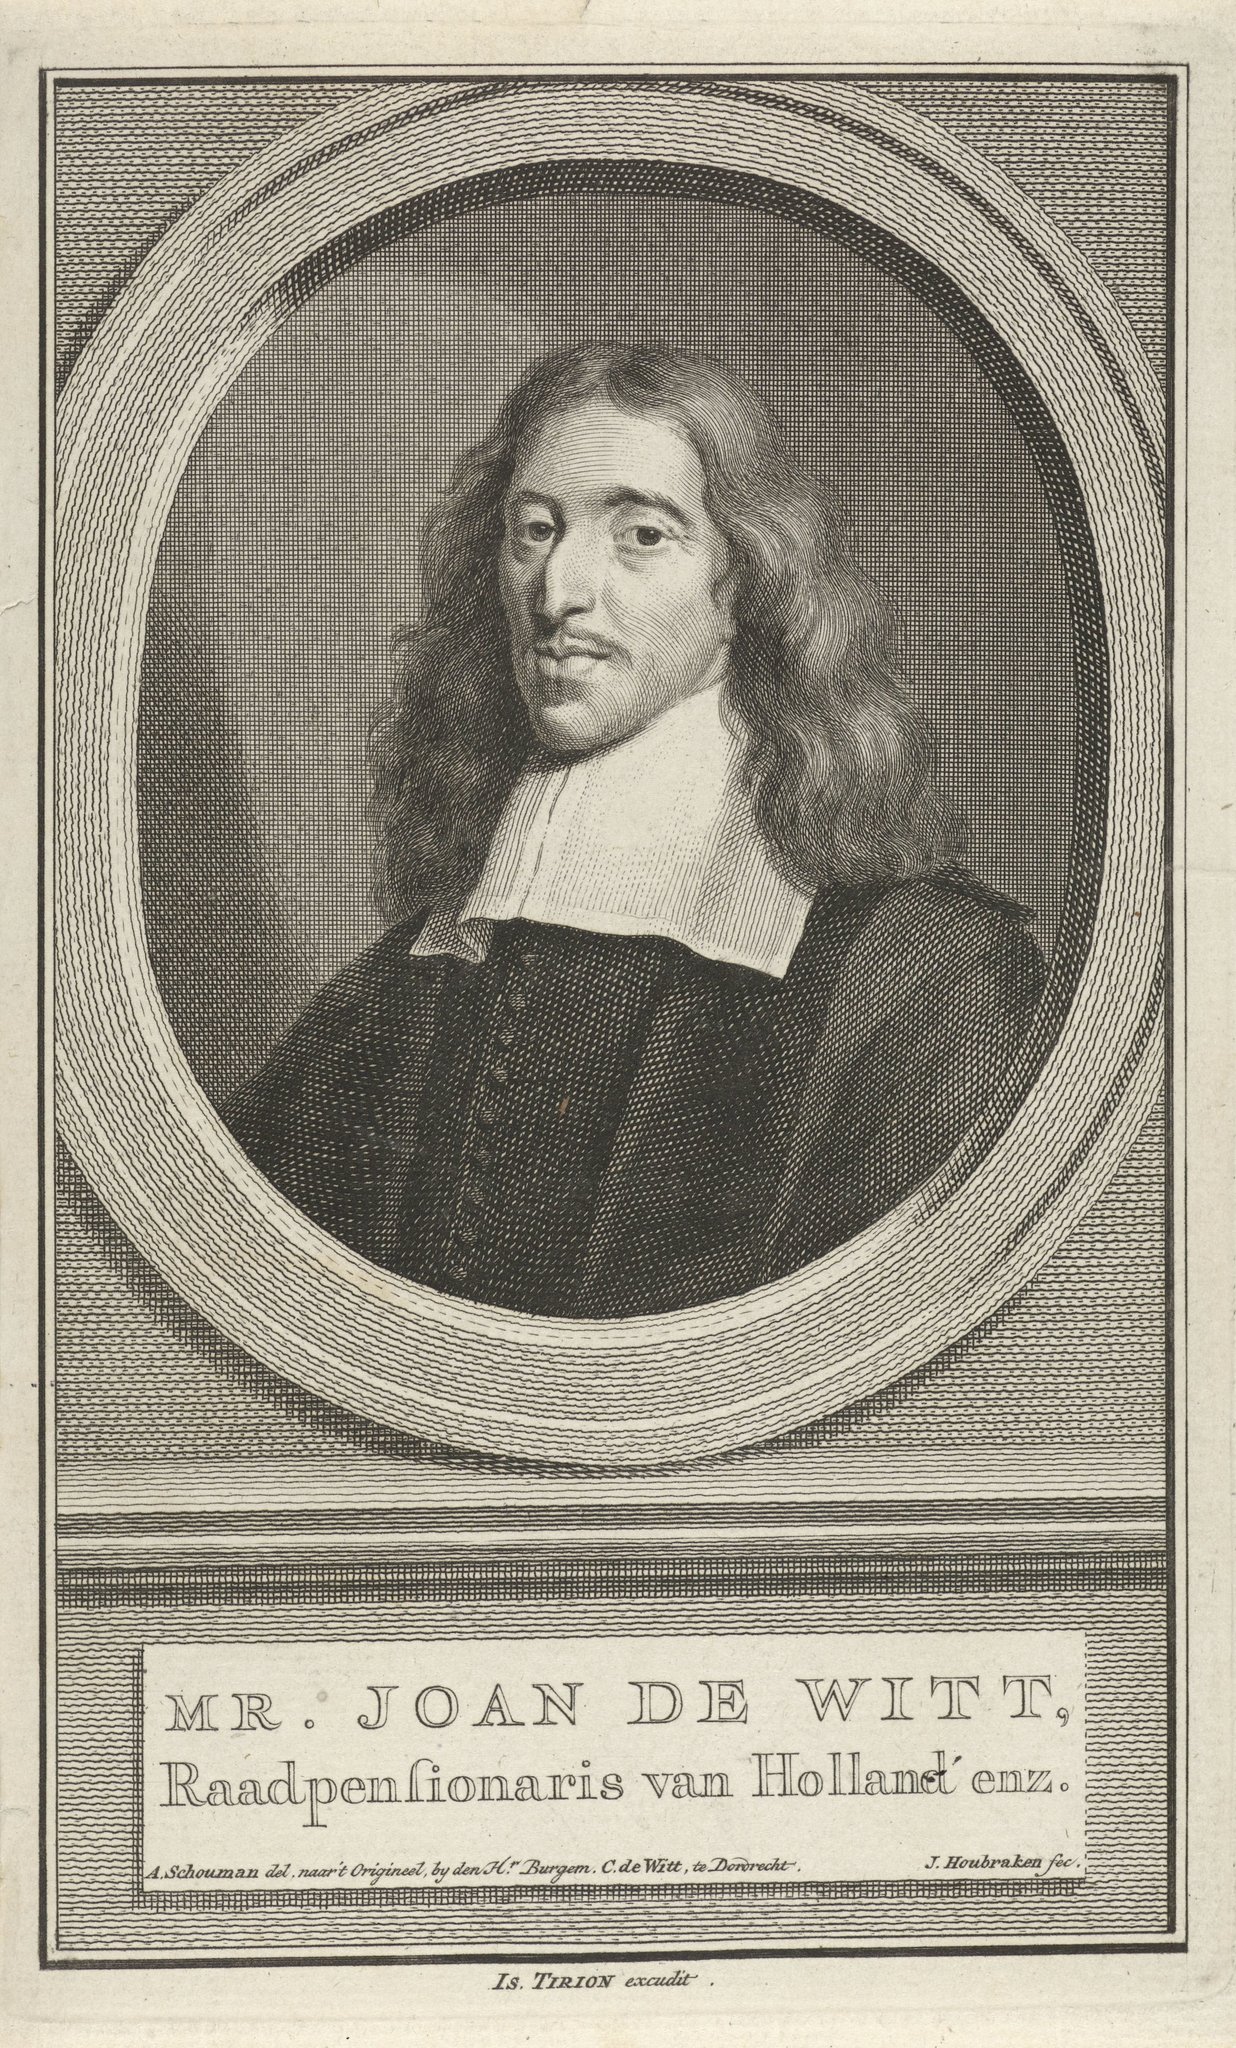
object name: print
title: Portret van Johann de Witt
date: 1749-1759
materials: paper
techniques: engraving, etching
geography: amsterdam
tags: johan de witt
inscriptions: collector's mark: Lugt 2228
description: Prent ook gebruikt in: Jan Wagenaar, Vaderlandsche historie, vervattende de geschiedenissen der nu Vereenigde Nederlanden, inzonderheid die van Holland (...), 21 delen. Amsterdam, Isaak Tirion, 1749-59.